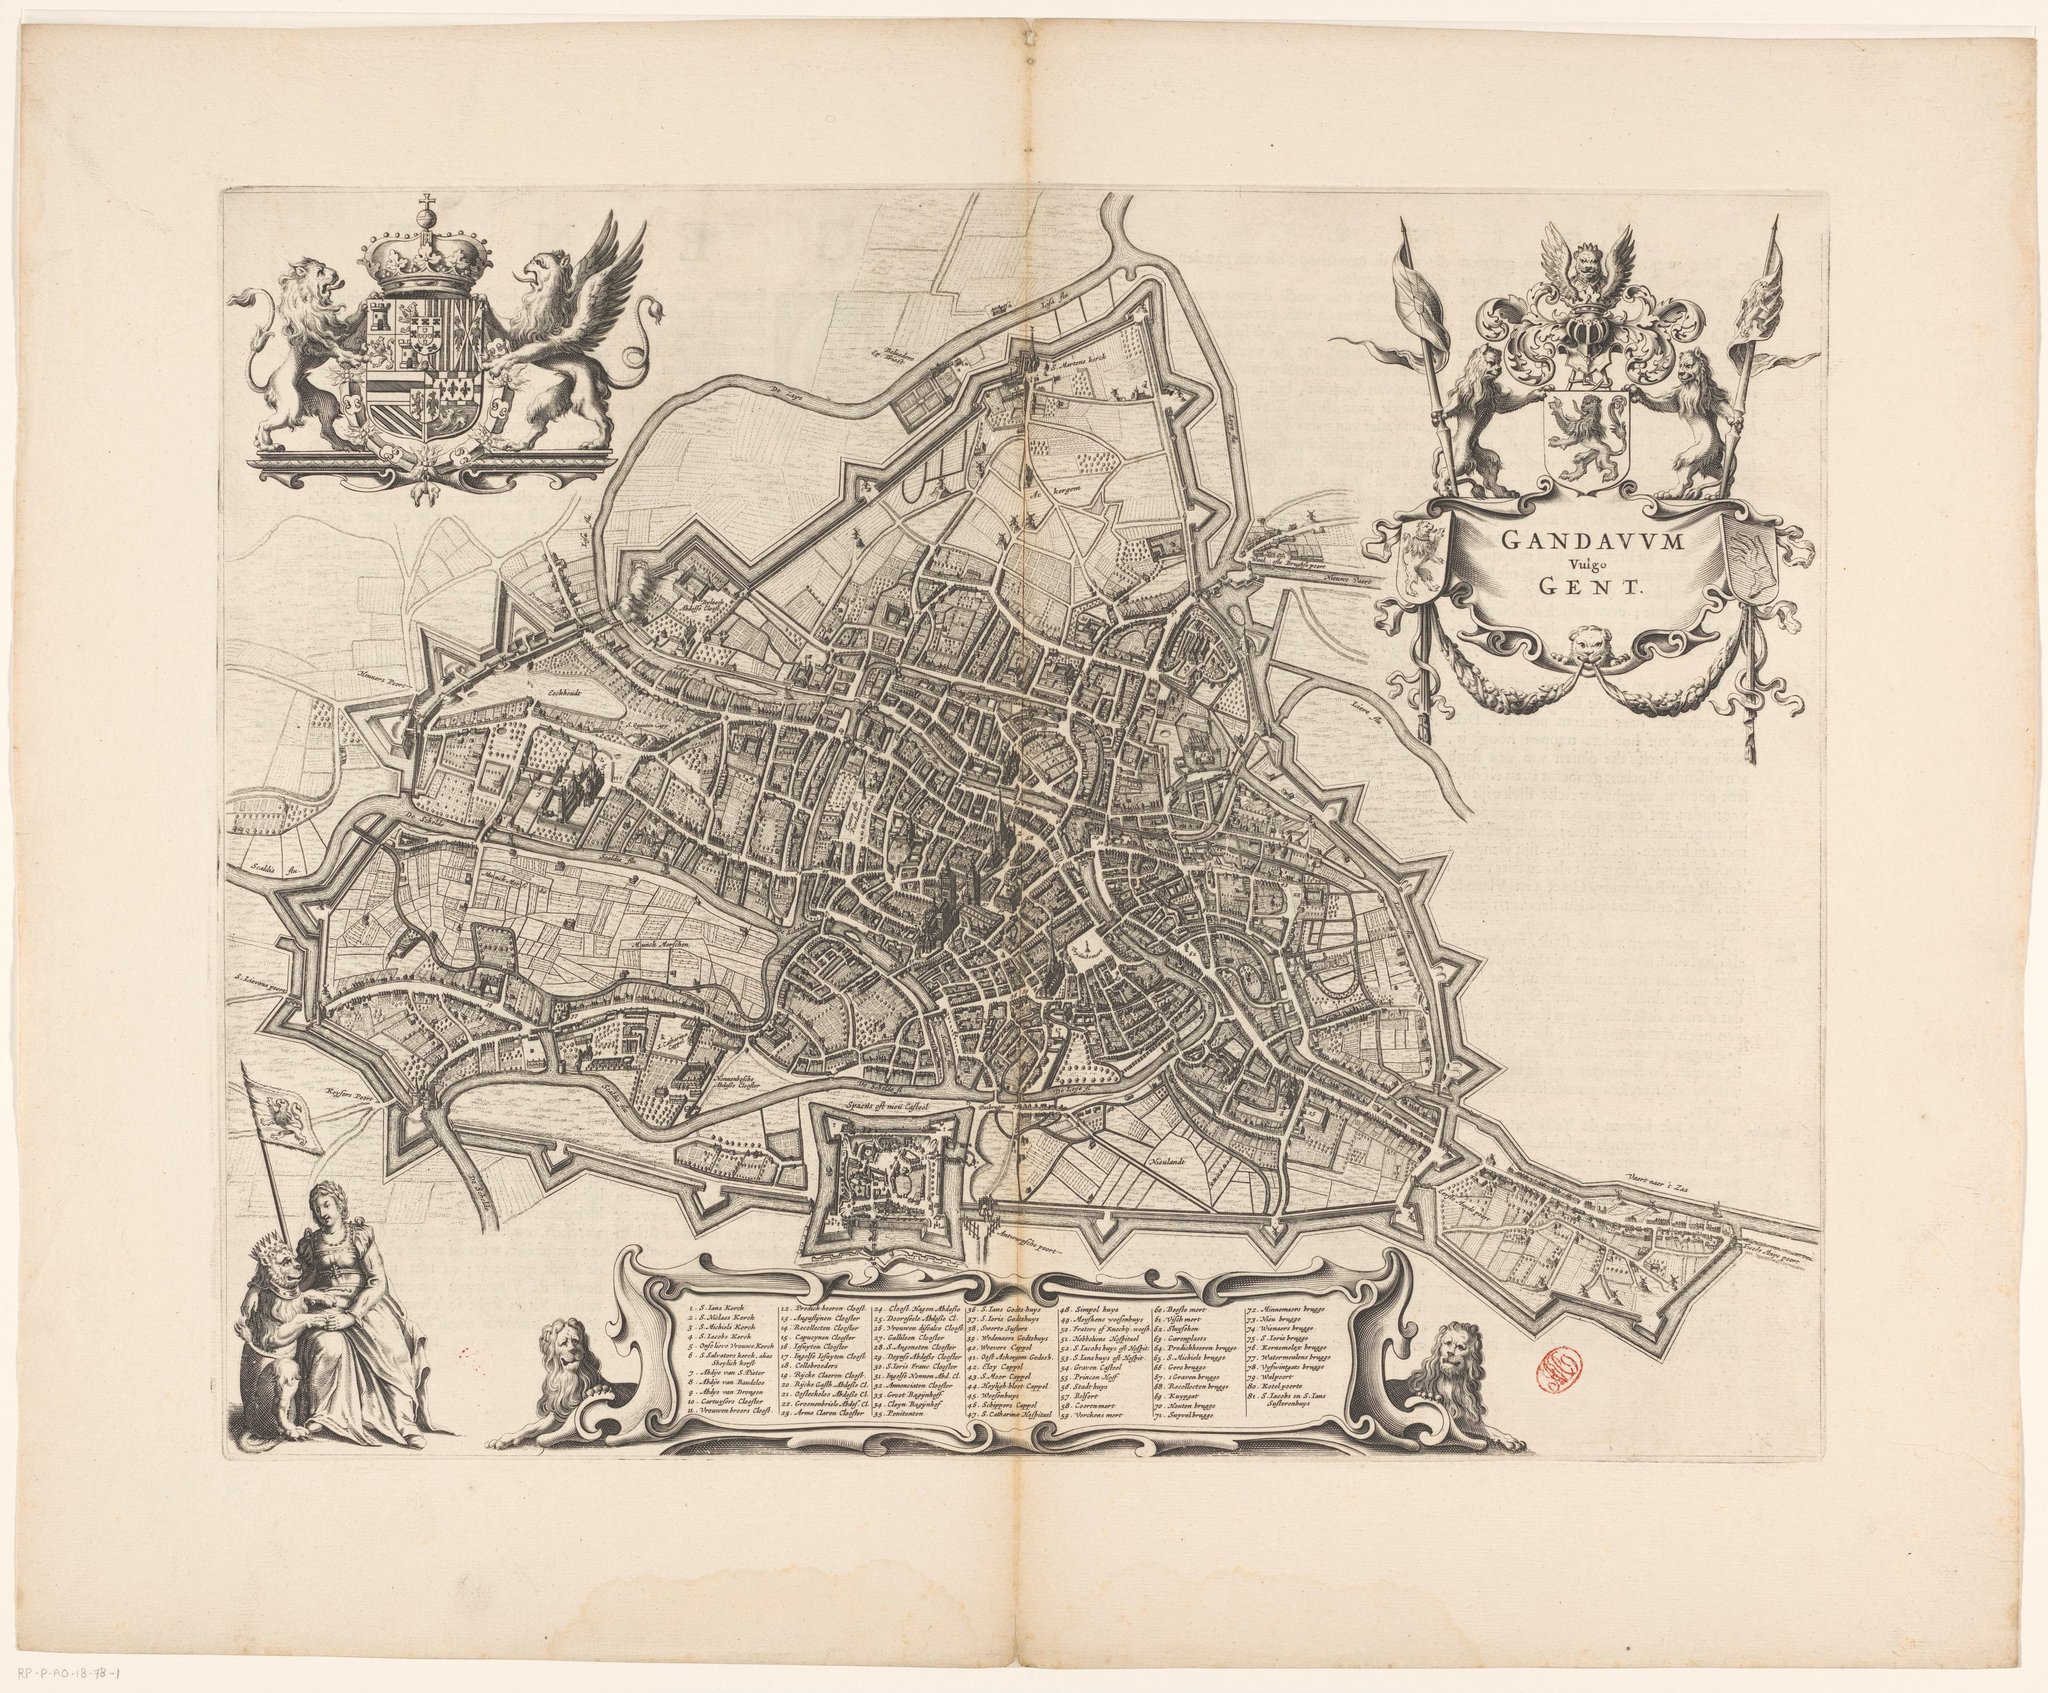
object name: area plan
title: Gandavum vulgo Gent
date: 1652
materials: paper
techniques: engraving, etching, letterpress printing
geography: amsterdam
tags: coat of arms (as symbol of the state, etc.) (+ city; municipal), maps of cities, beasts of prey, predatory animals: lion, coat of arms (as symbol of the state, etc.) (+ province; provincial), armorial bearing, heraldry, ghent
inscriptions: collector's mark: Lugt 195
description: Plattegrond van Gent met gebouwen in vogelvluchtperspectief. Rechtsboven de titelcartouche met bovenin het wapen van Vlaanderen, links het wapen van Gent en rechts een wapenschild met handschoen, waarschijnlijk een voormalig wapen van Gent. Linksboven het wapen van de koning van Spanje. Onder, in het midden, een cartouche met legenda 1-81. Linksonder de zittende Maagd van Gent met de zittende leeuw van Gent, de banier van Vlaanderen tussen beiden. Met Nederlandse tekst op verso.